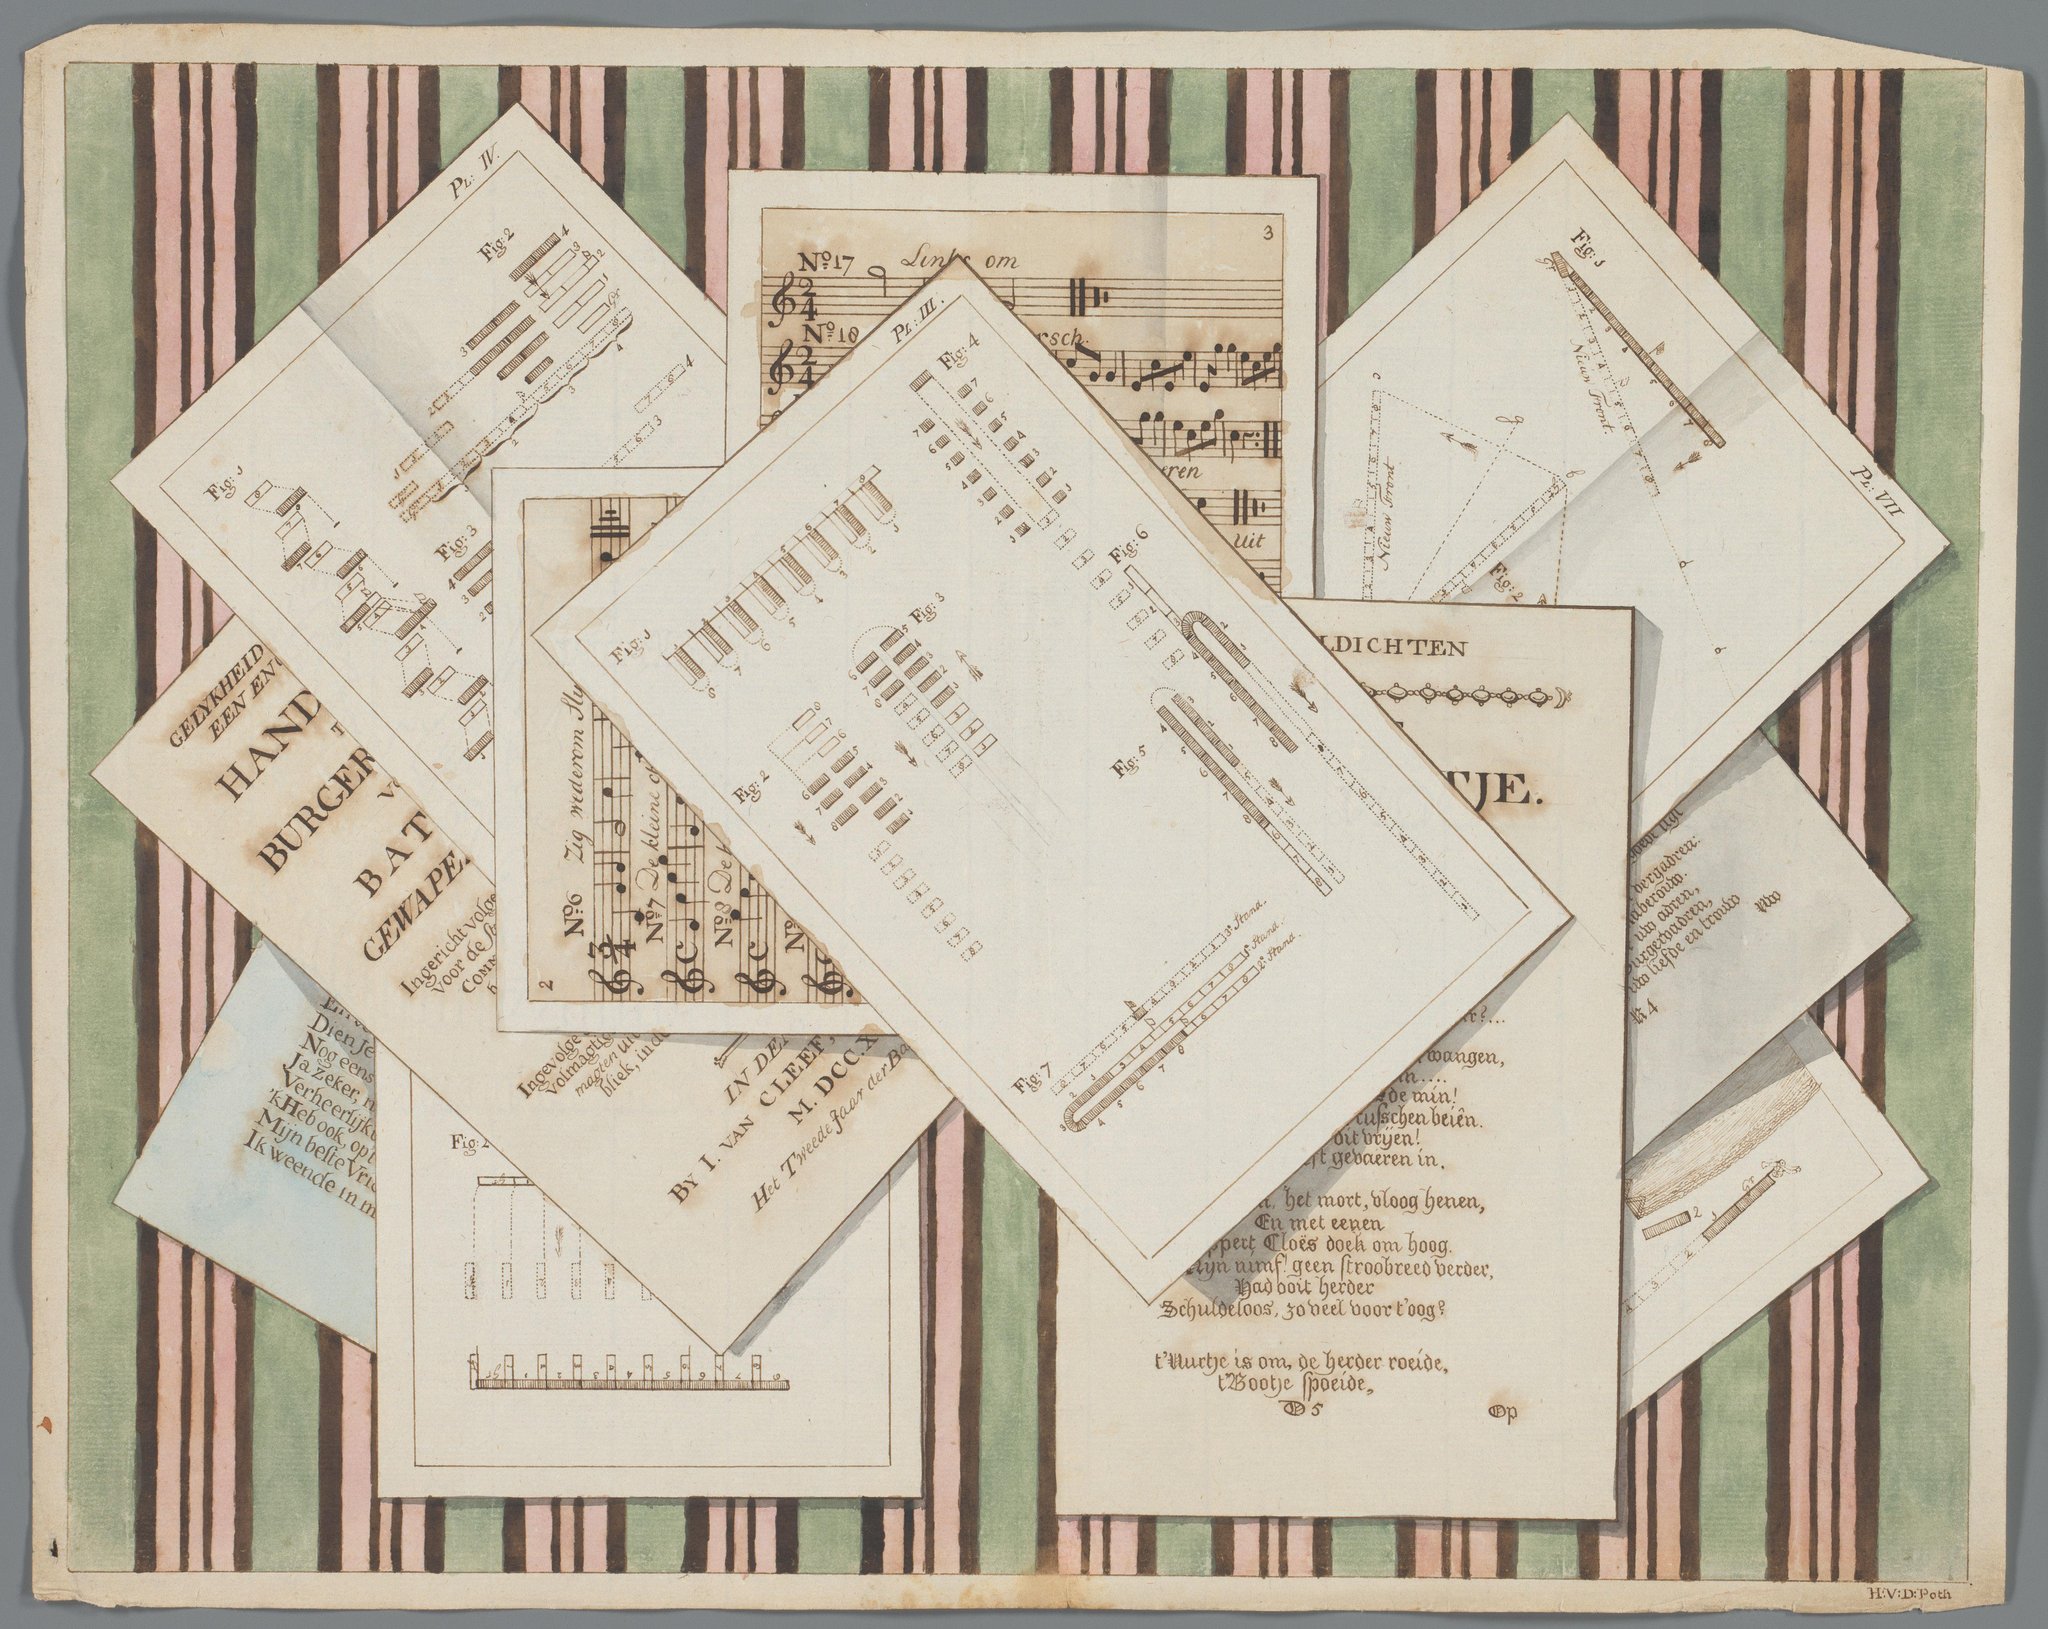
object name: trompe l'oeil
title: Boerenbedrieger met bladen met manoeuvres, ca. 1799-1803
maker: hendrik van der poth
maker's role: draughtsman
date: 1799-1803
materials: paper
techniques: writing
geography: netherlands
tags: 'trompe l'oeil', manoeuvre ~ military training, manuscript of musical score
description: Boerenbedrieger of trompe-l'oeil bestaande uit elf bladen papier met plattegronden van manoeuvres, muziekbladen, verzen en pamfletten, ca. 1799-1803.